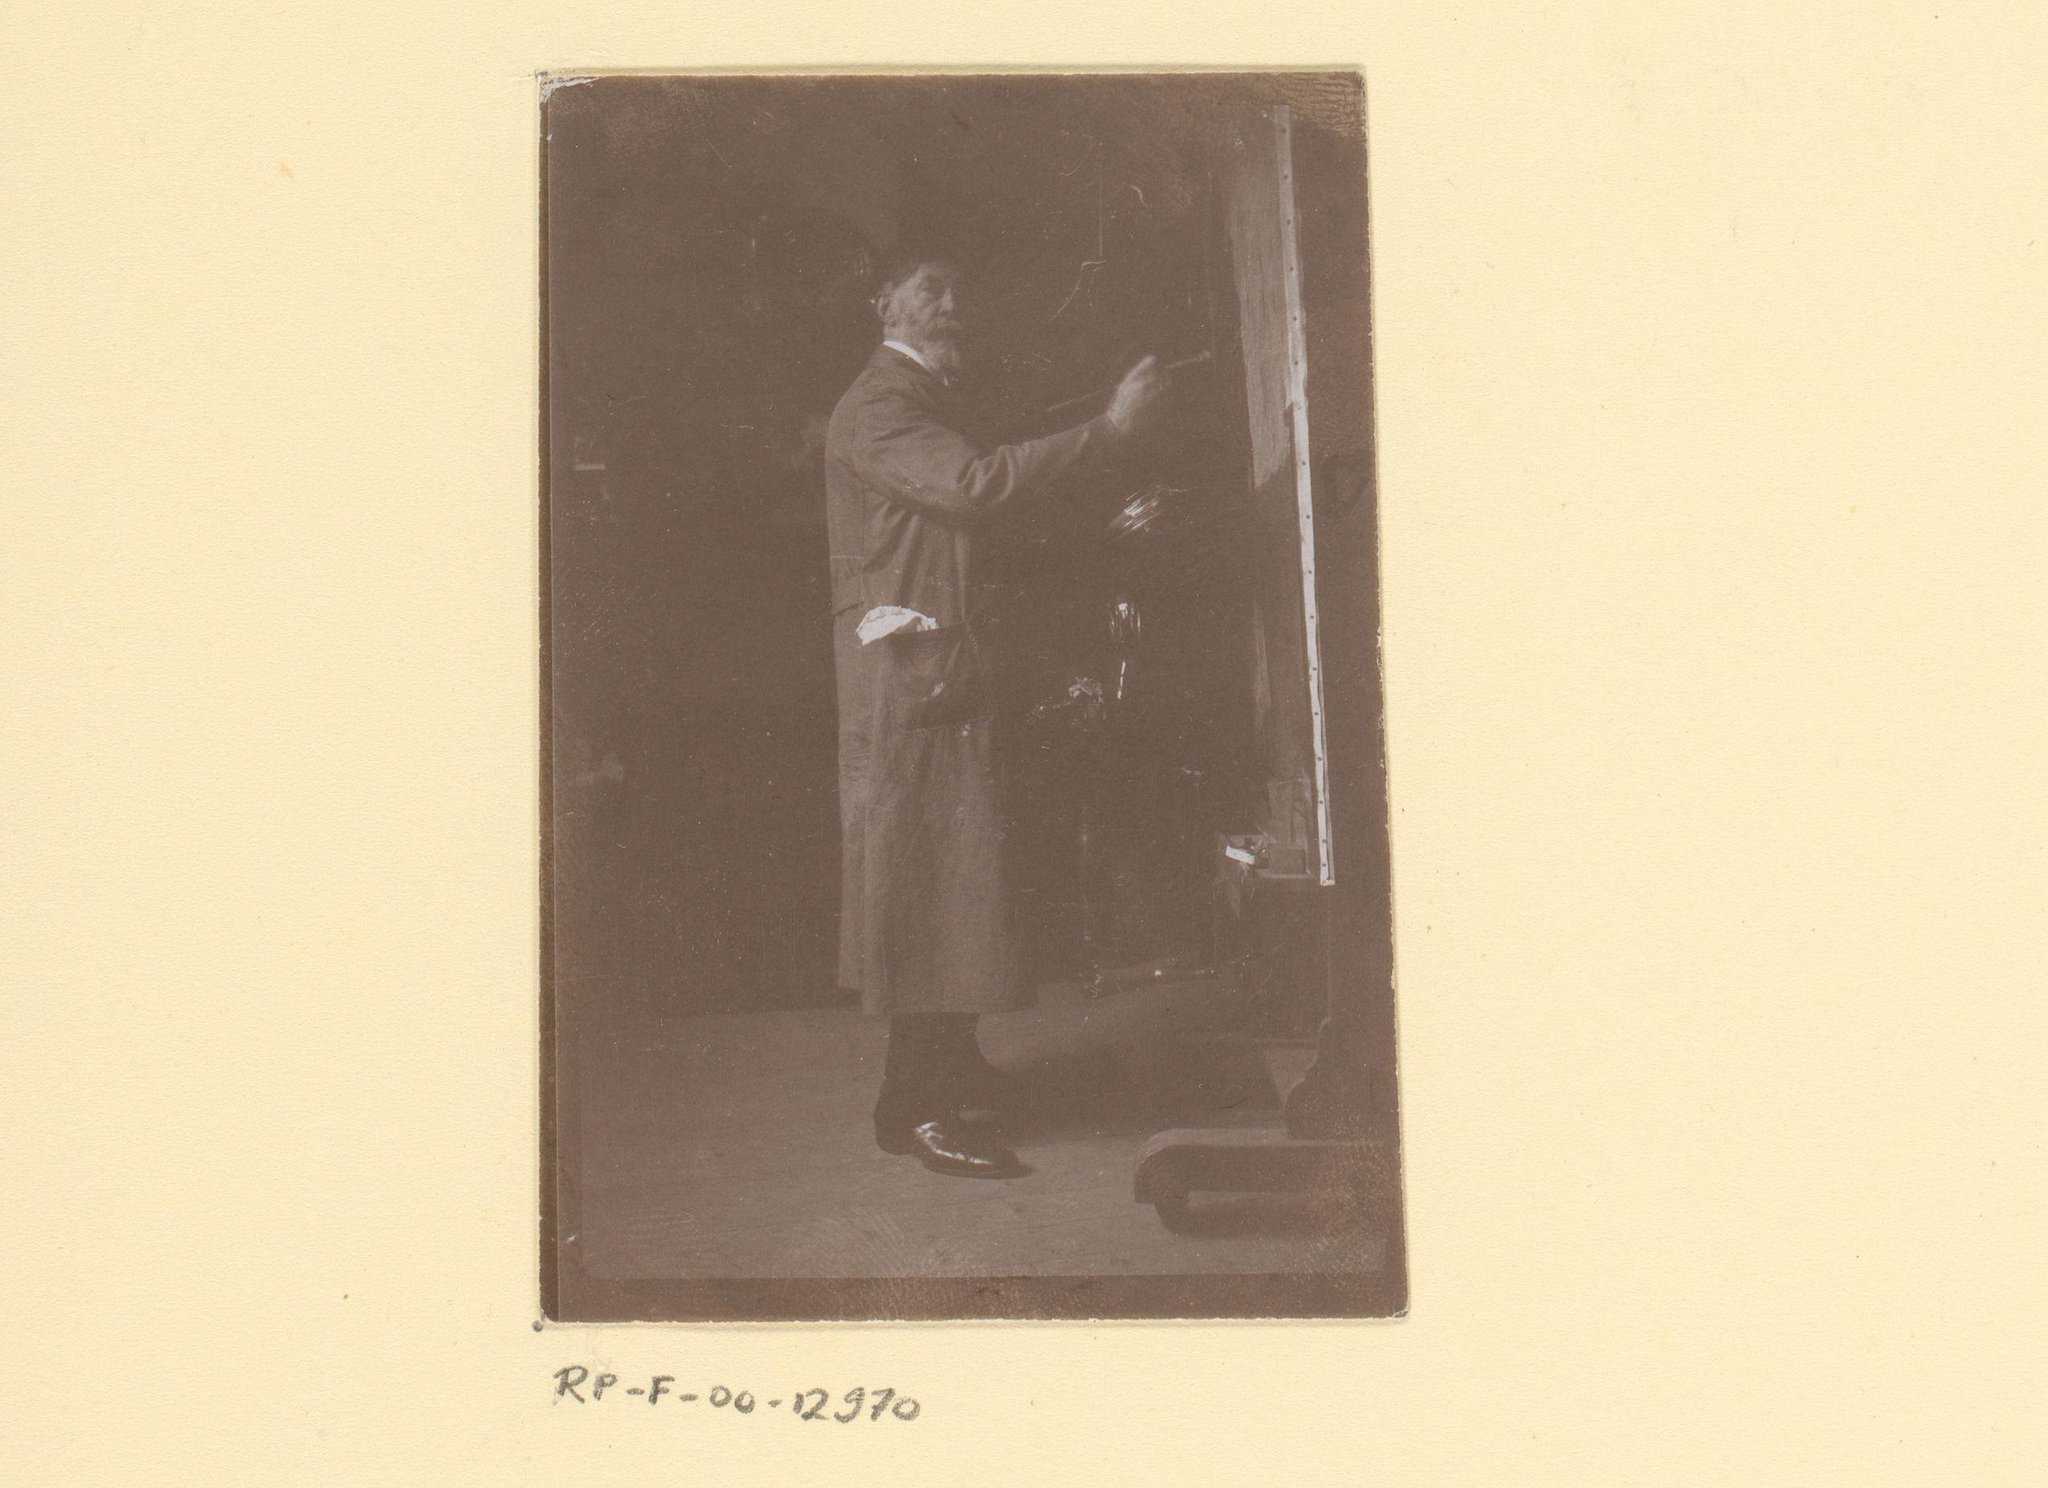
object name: photograph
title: Portret van Ferdinand Oldewelt, schilderend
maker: Anonymous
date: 1900-1920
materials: paper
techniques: collodion silver print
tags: print maker, draughtsman, ferdinand oldewelt, historical persons, portrait, self-portrait of artist, working situations ~ painter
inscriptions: inscription: ‘FGW Oldewelt’